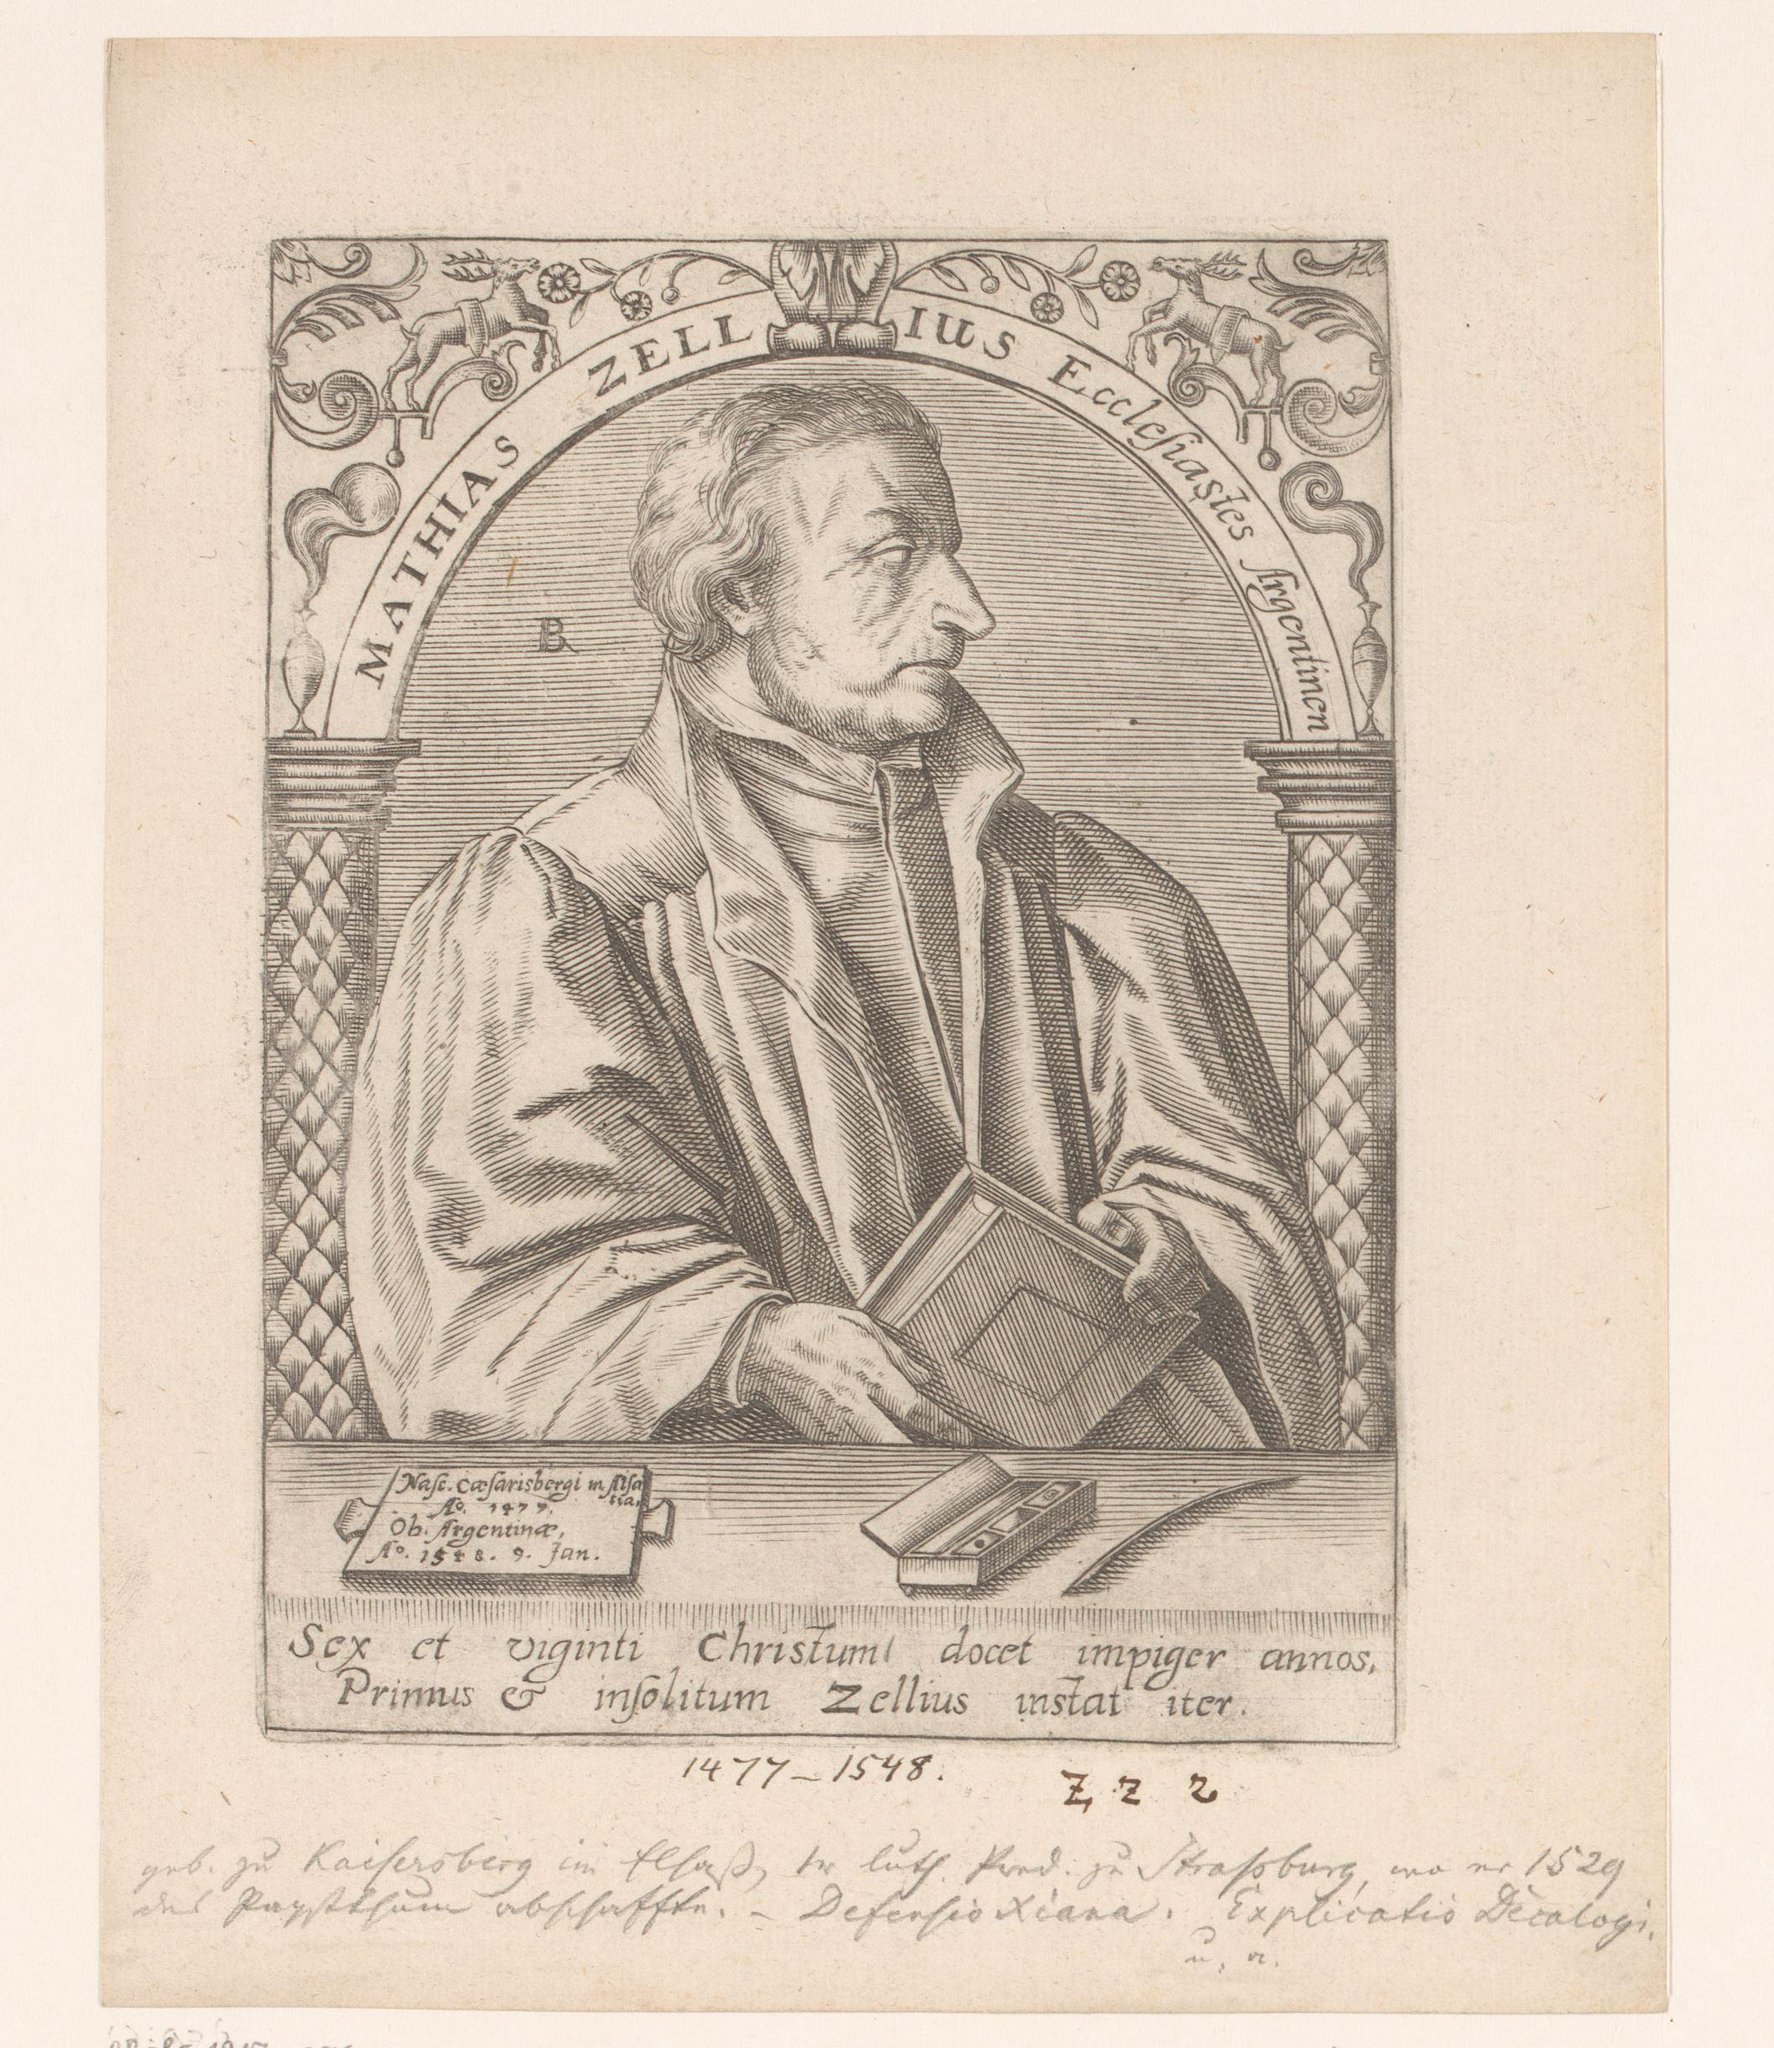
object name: print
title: Serie portretten van vijftiende- en zestiende-eeuwse geleerden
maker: robert boissard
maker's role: print maker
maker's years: 1570-1611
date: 1597-1599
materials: paper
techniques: engraving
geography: france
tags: hoofed animals: deer - ff - fabulous animals (sometimes wrongly called 'grotesques'); 'mostri' (ripa), historical persons, book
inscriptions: collector's mark: Lugt 2228